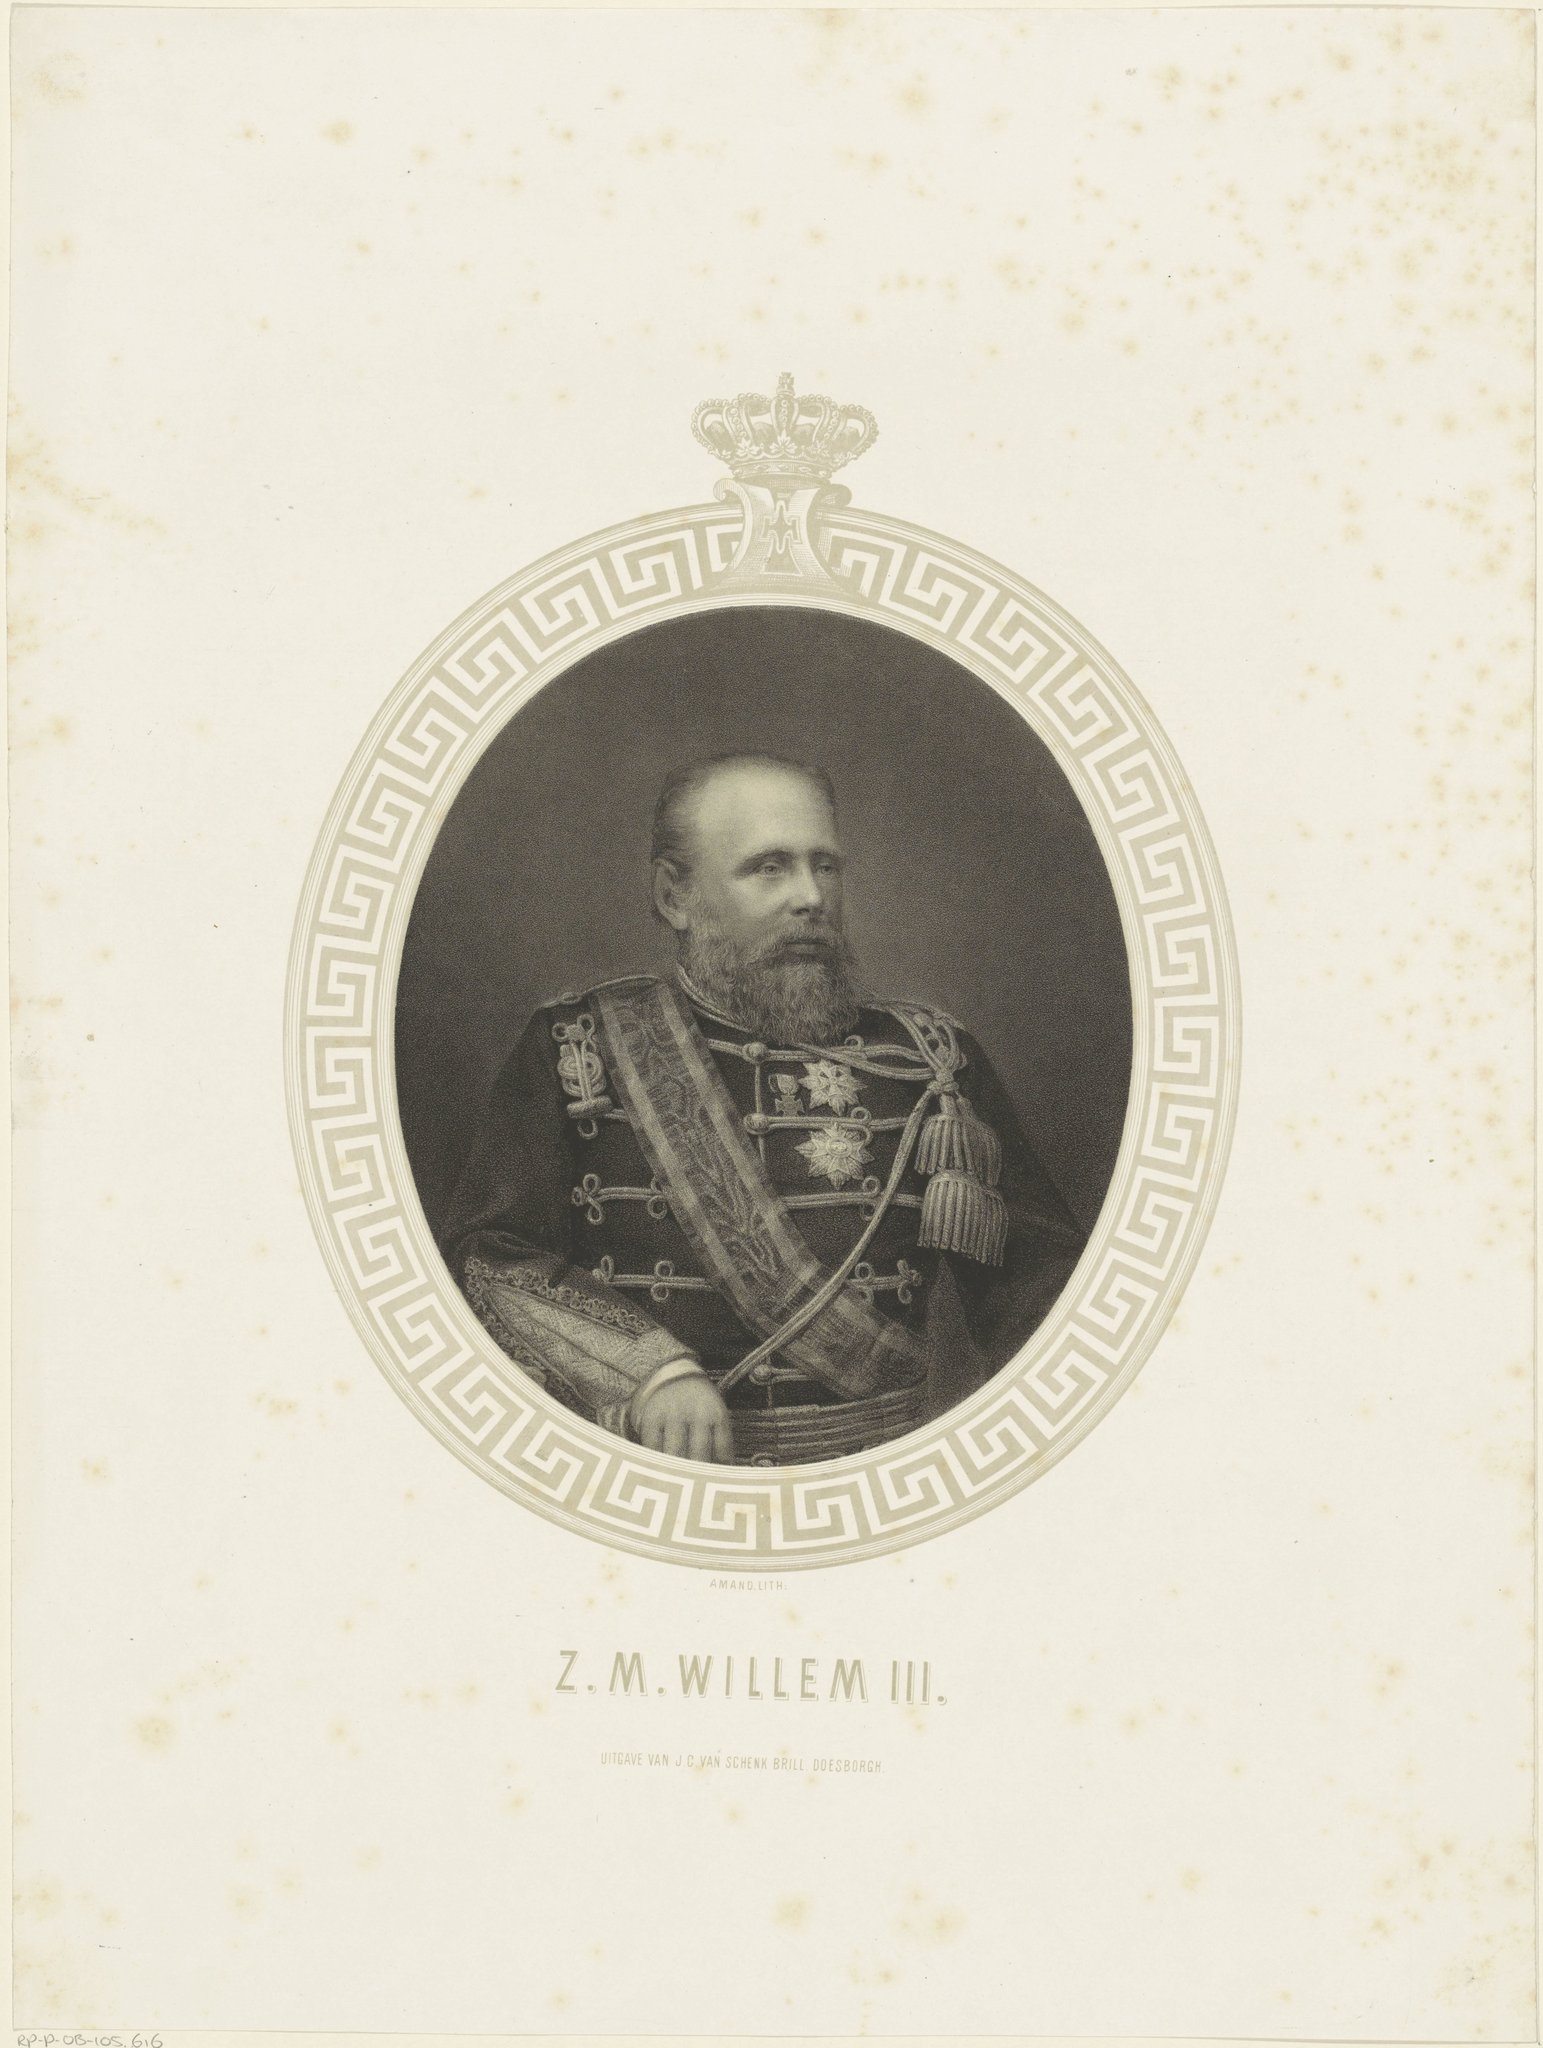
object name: print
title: Portret van Willem III, koning der Nederlanden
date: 1870-1894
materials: paper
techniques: tone lithography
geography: amsterdam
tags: brussels, willem iii (koning der nederlanden)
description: De hier vermelde titel verwijst naar de hoogst verkregen titel van de geportretteerde, niet per se naar de titel die de geportretteerde op deze voorstelling draagt.